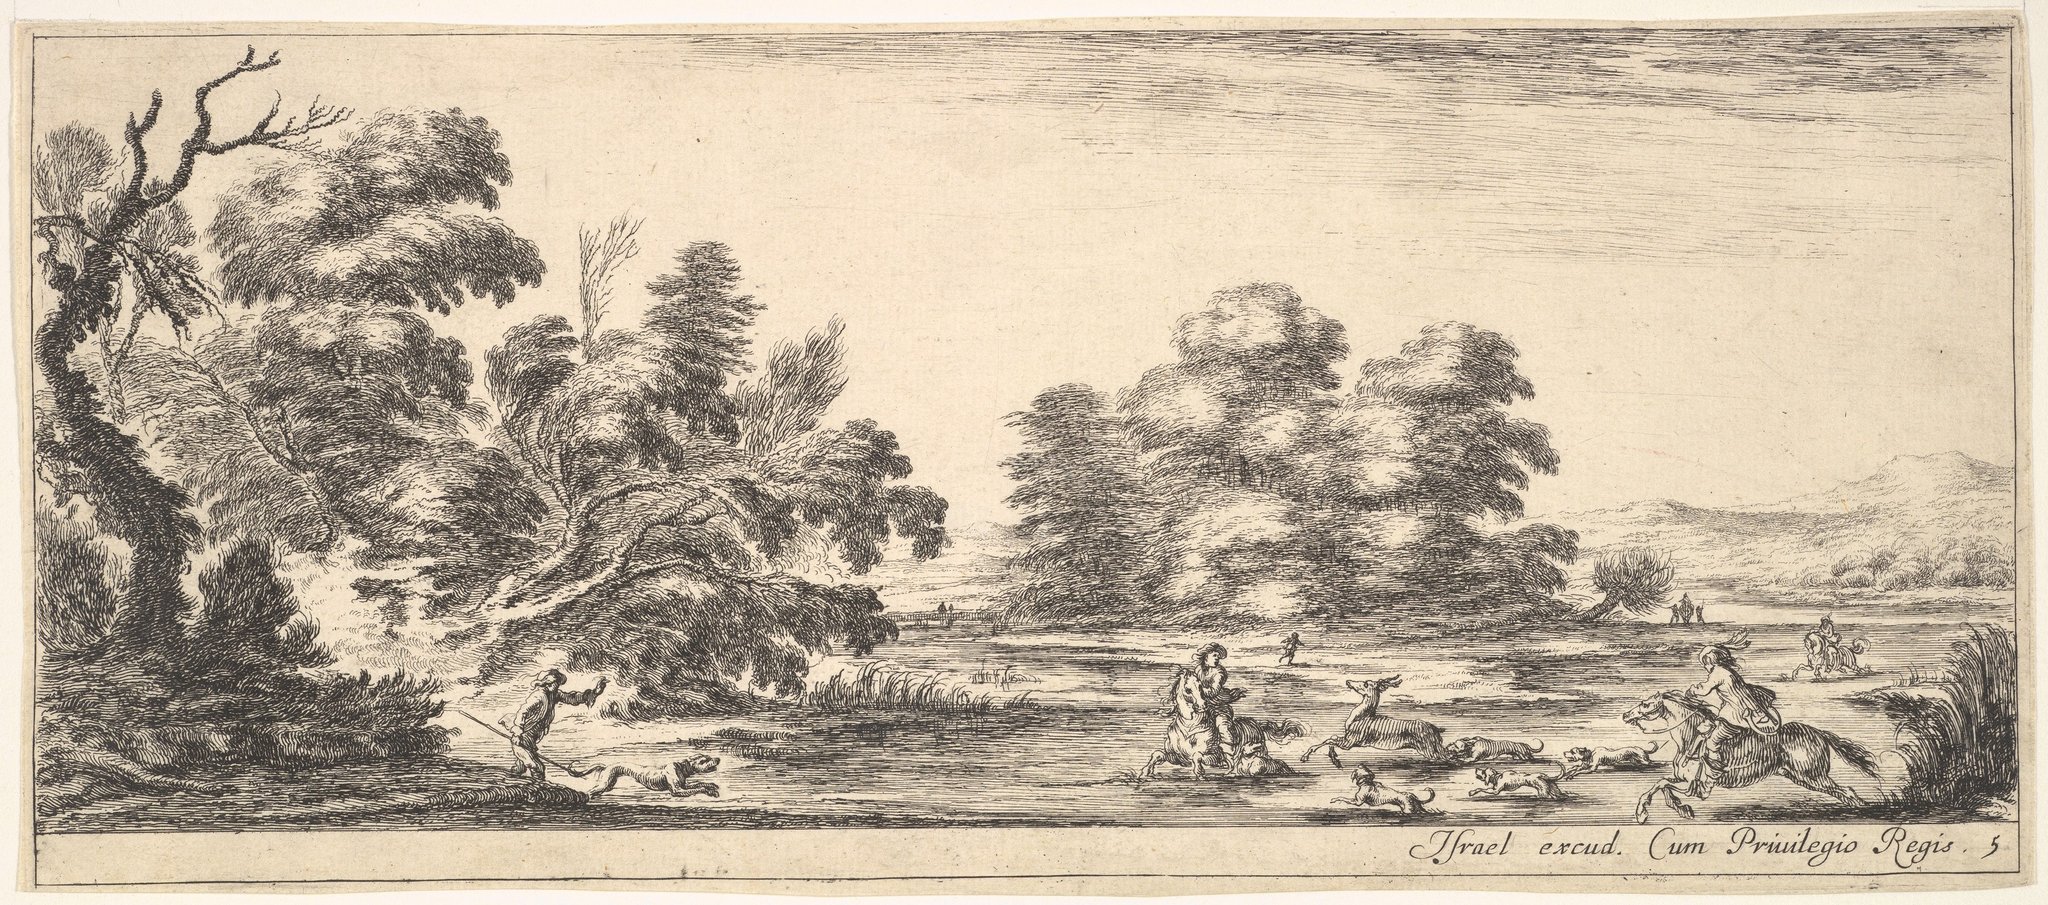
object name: print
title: Plate 5: two horsemen in a stream to right, riding towards the left, following four dogs chasing a stag, another dog running into the water from the left, from "Various Landscapes" (Divers Paysages)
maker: stefano della bella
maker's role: artist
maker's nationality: italian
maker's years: 1610-1664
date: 1641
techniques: etching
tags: human figures,dogs,horses,landscapes,trees